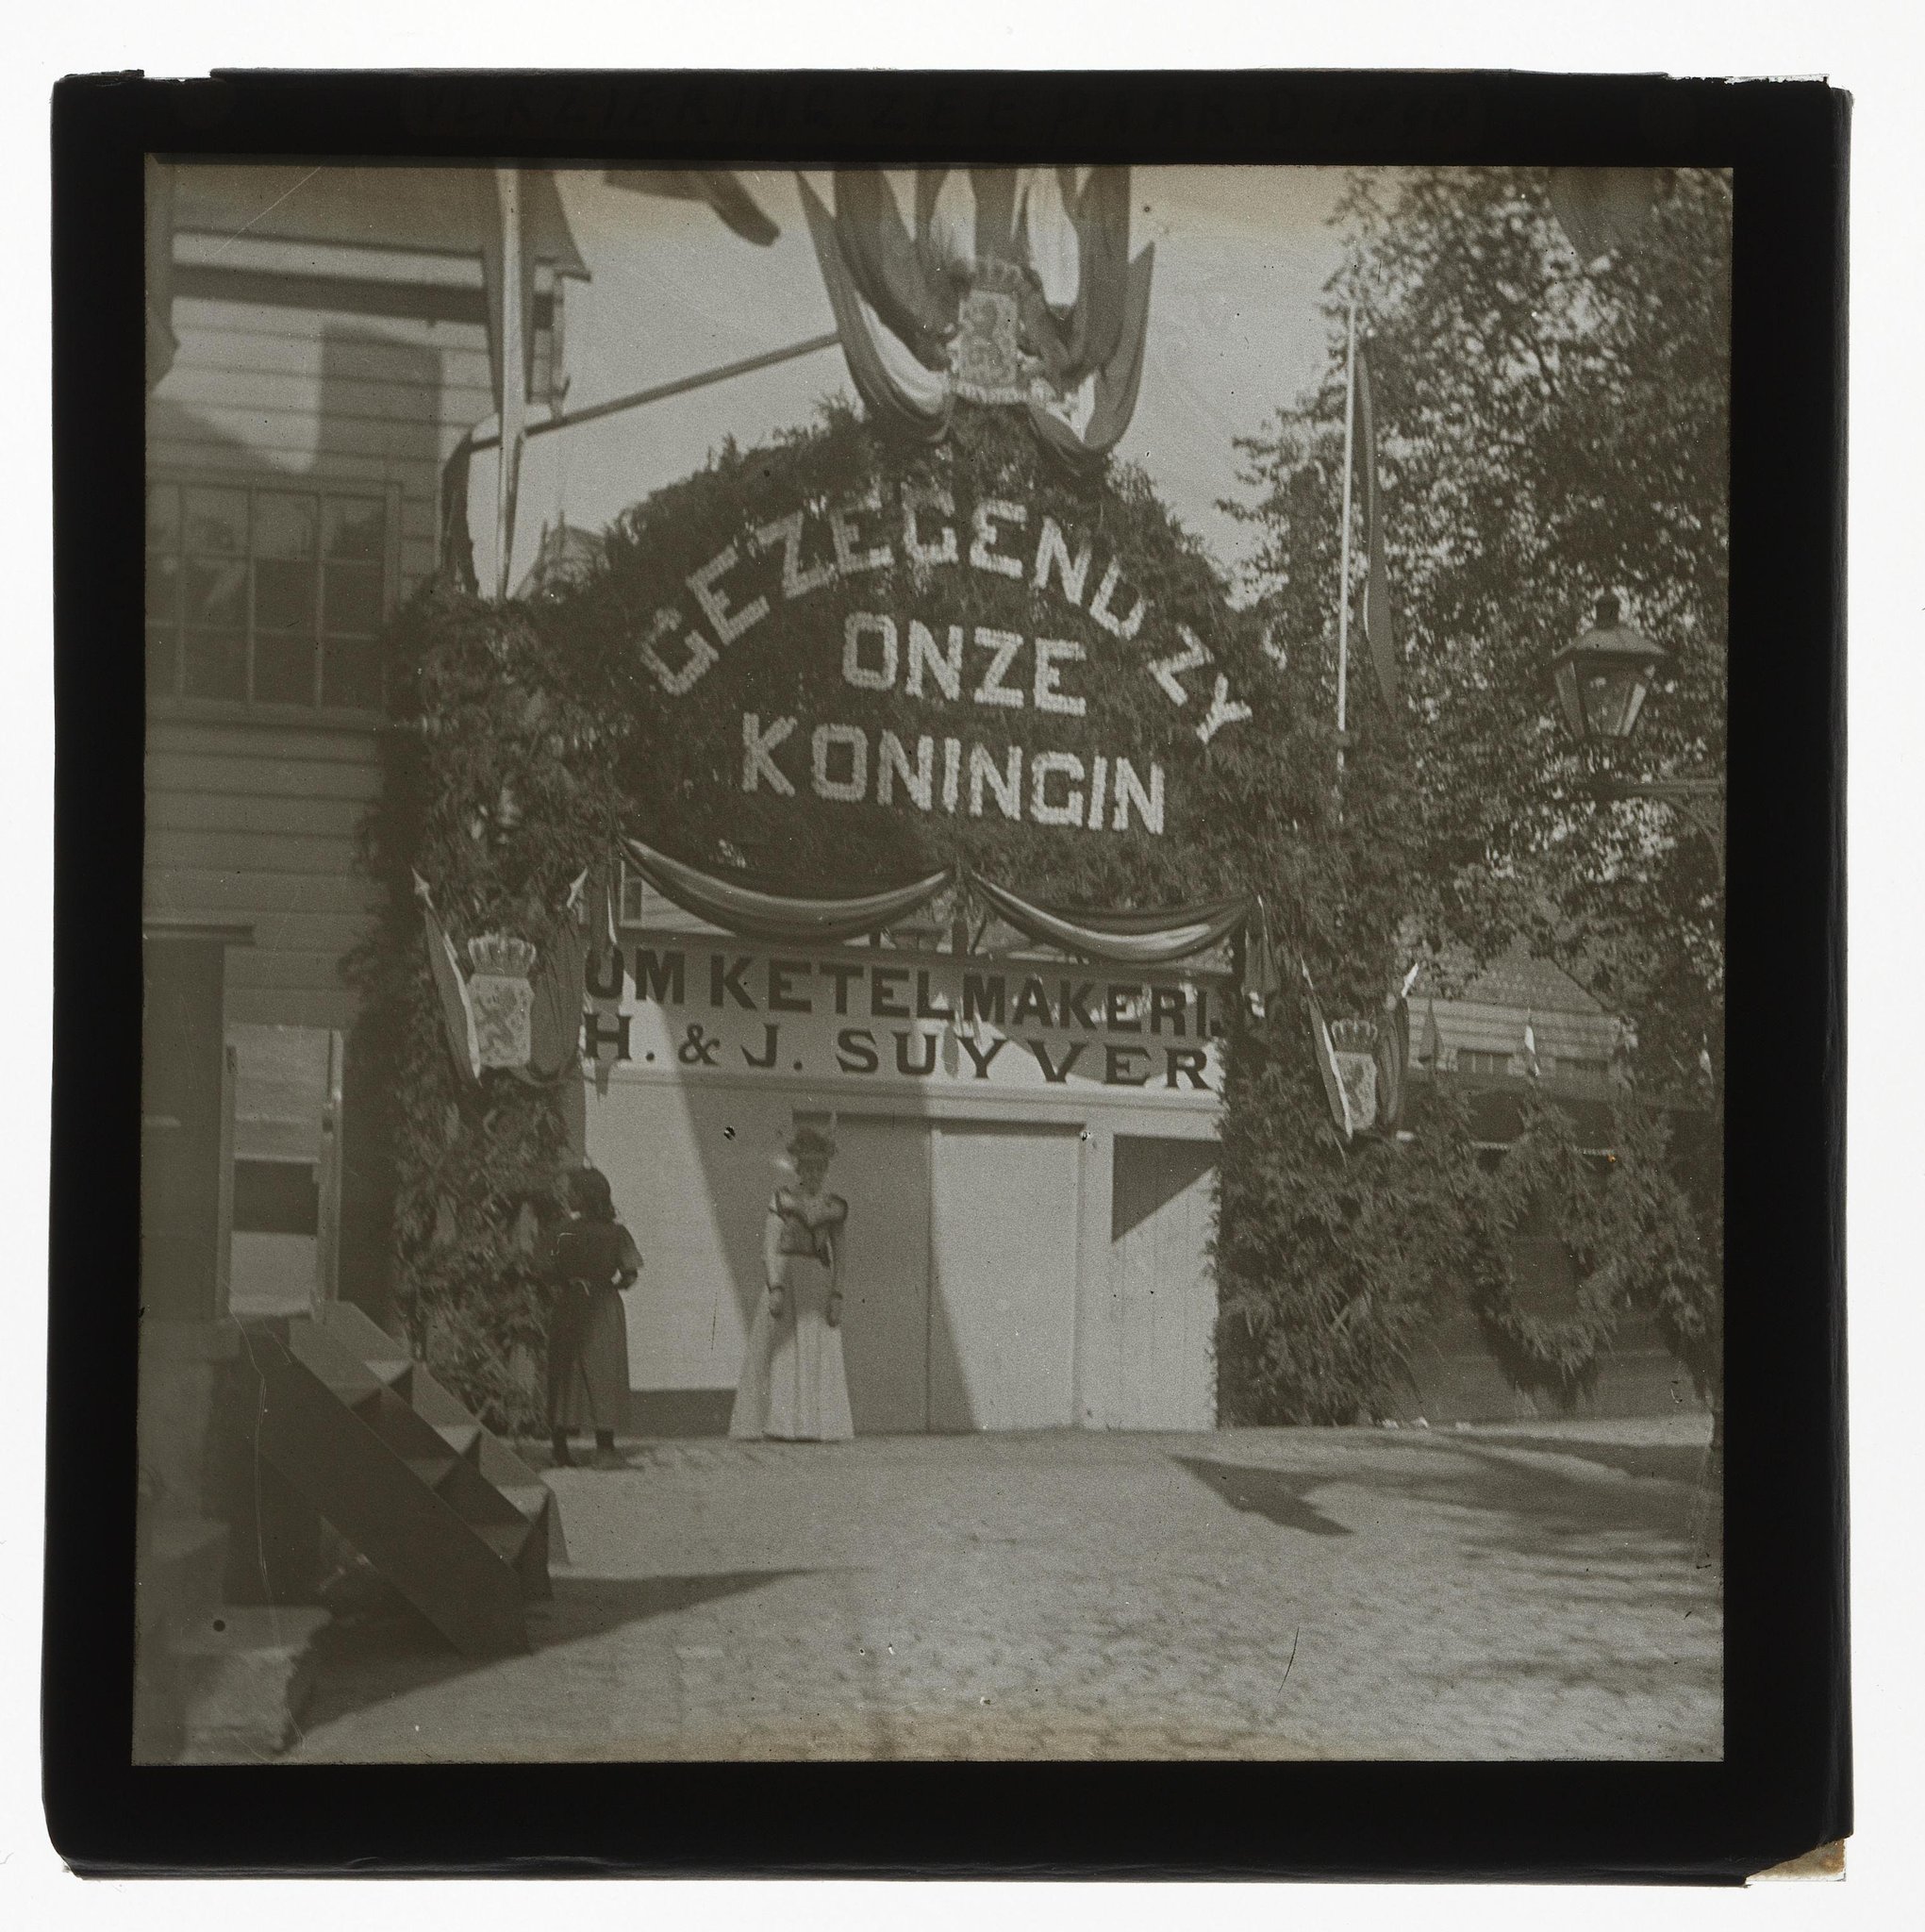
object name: lantern slide photographic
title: Verkiezing zeepaard 1898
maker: machiel gerrit george suyver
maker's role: fotograaf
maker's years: 1872-1933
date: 1898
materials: glass, paper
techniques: gelatin silver transparency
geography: amsterdam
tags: adolescent, young woman, maiden, adult woman, amsterdam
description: Mejuffrouw A. Schogt, verloofde van M.G.G. Suyver, en een onbekend meisje voor de versierde ingang van Ketelmakerij H.& J. Suyver. Er werd meegedaan aan wedstrijd mooiste versiering n.a.v. troonsbestijging van koningin Wilhelmina.